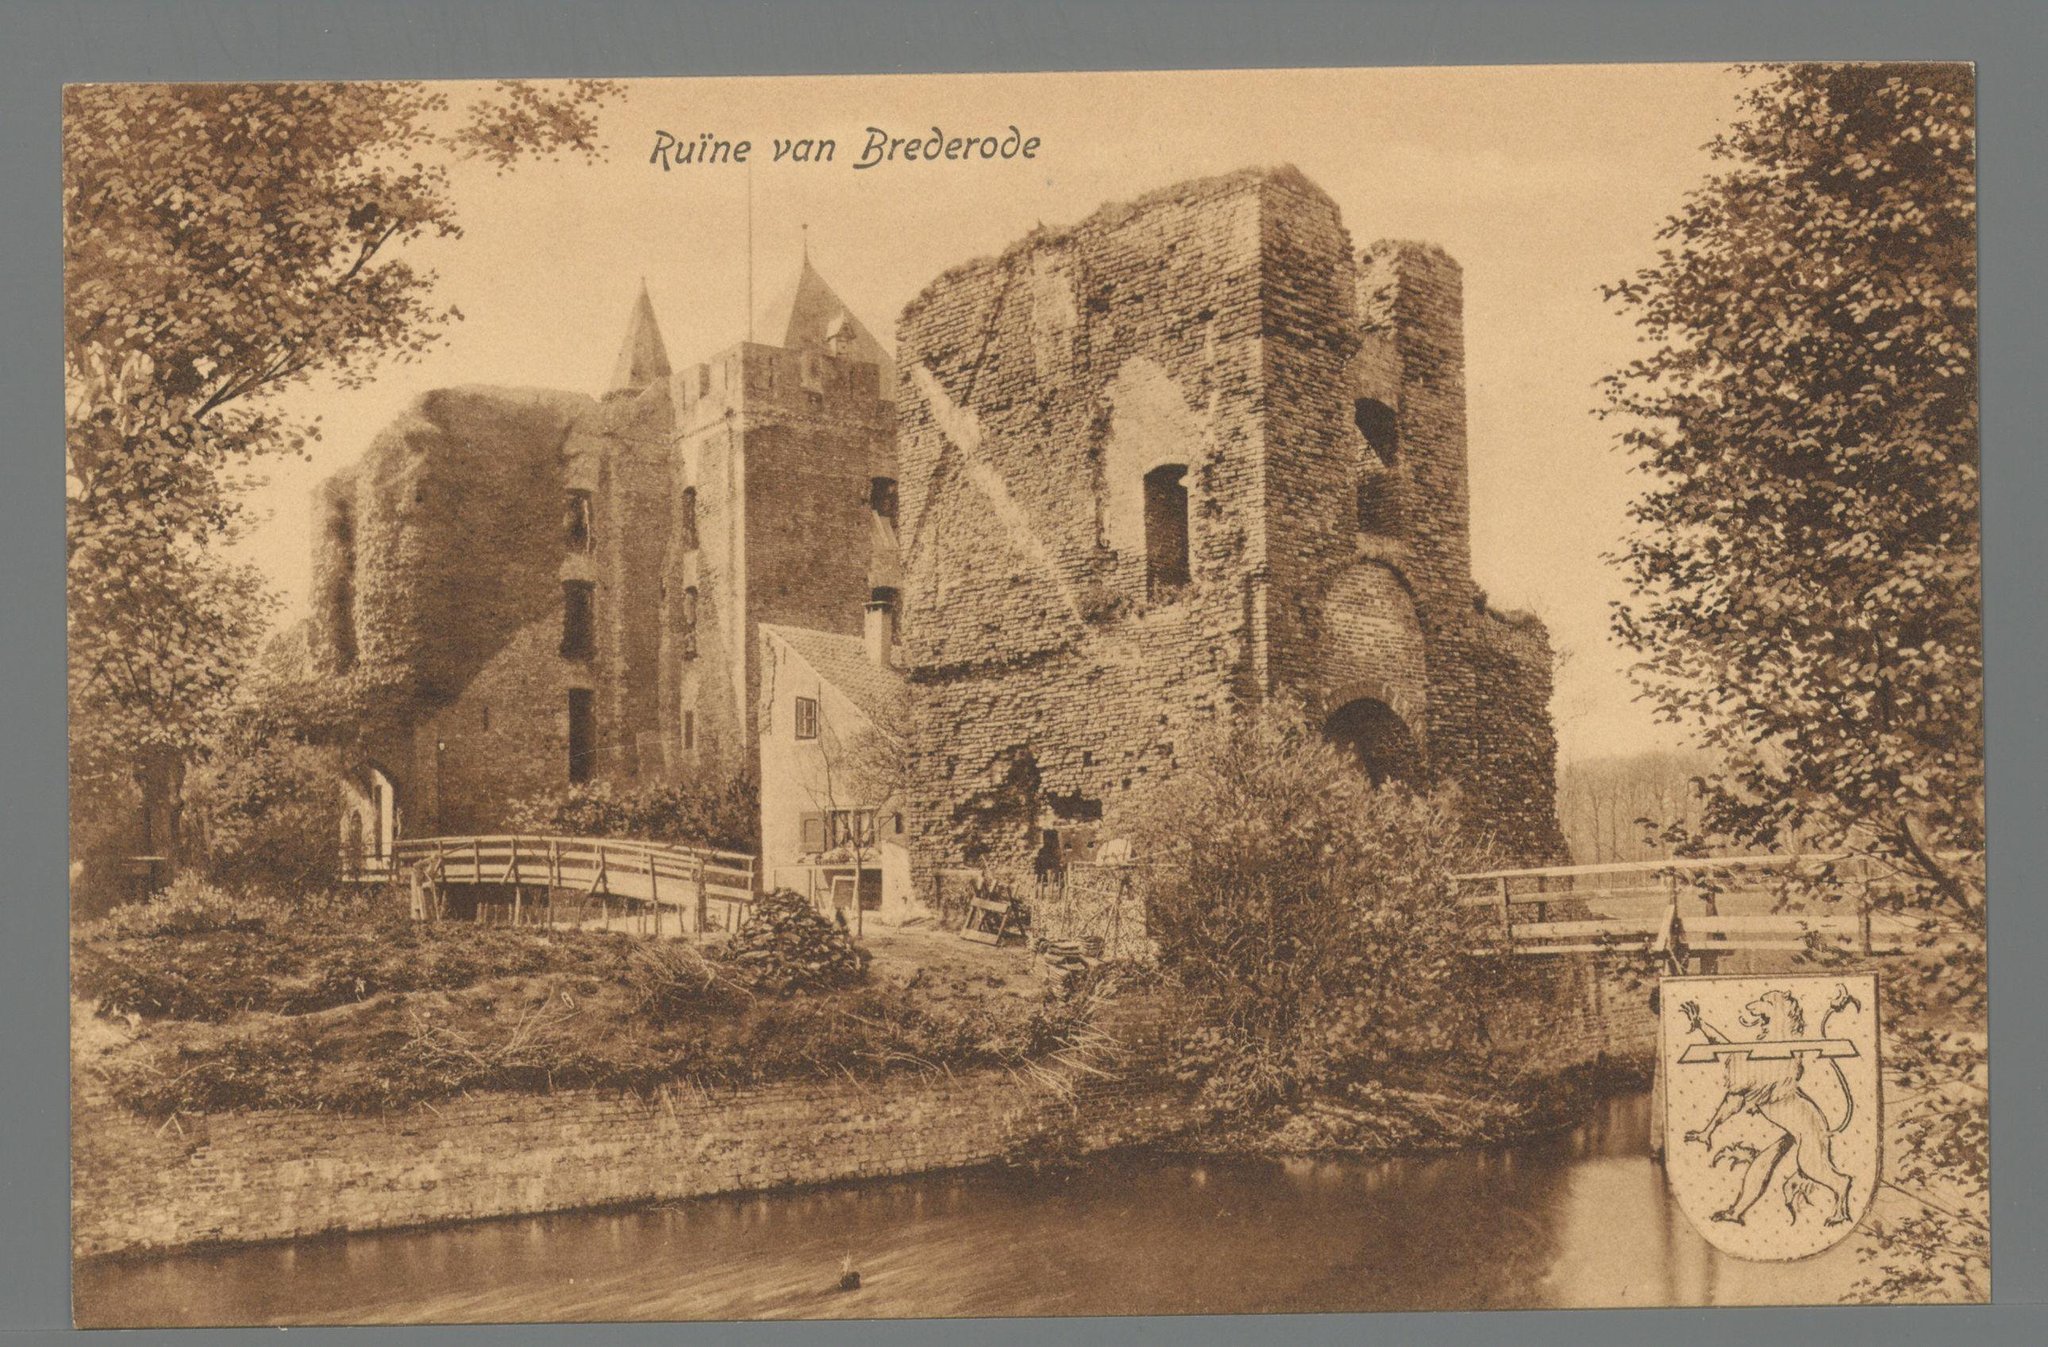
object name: ansichtkaart, prentbriefkaart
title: Ruïne van Brederode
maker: Anonymous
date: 1913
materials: cardboard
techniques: photograph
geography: santpoort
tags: castle, bridge in city across river, canal, etc., armorial bearing, heraldry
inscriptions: date